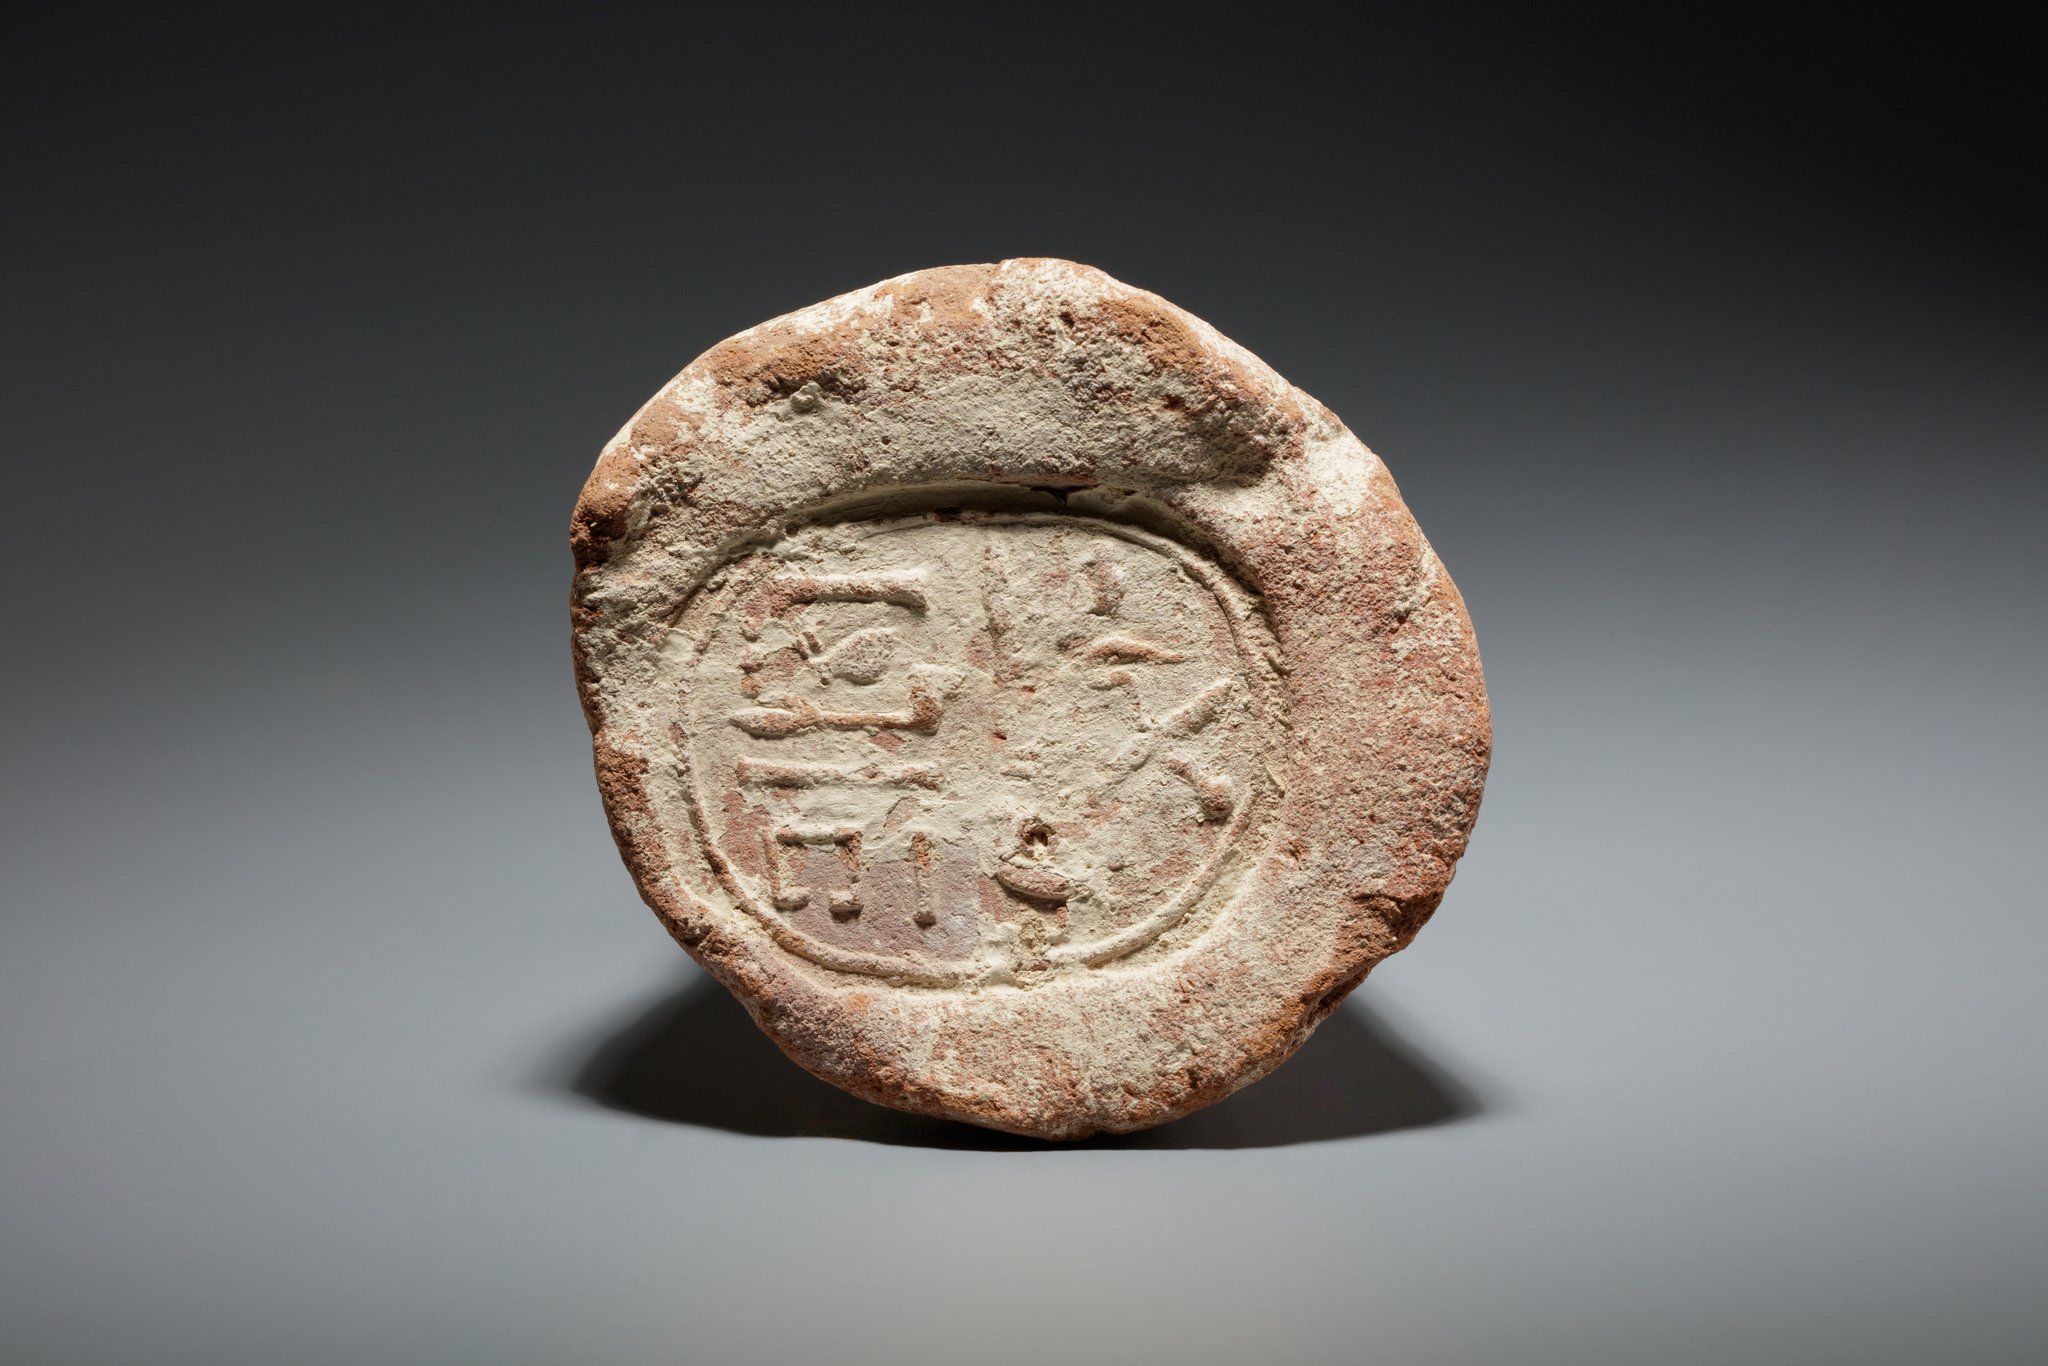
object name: cone, davy 309, pasanesut, servant, royal palace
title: Funerary Cone of Pasanesut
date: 1550-1295 BCE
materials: pottery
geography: egypt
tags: hieroglyphs